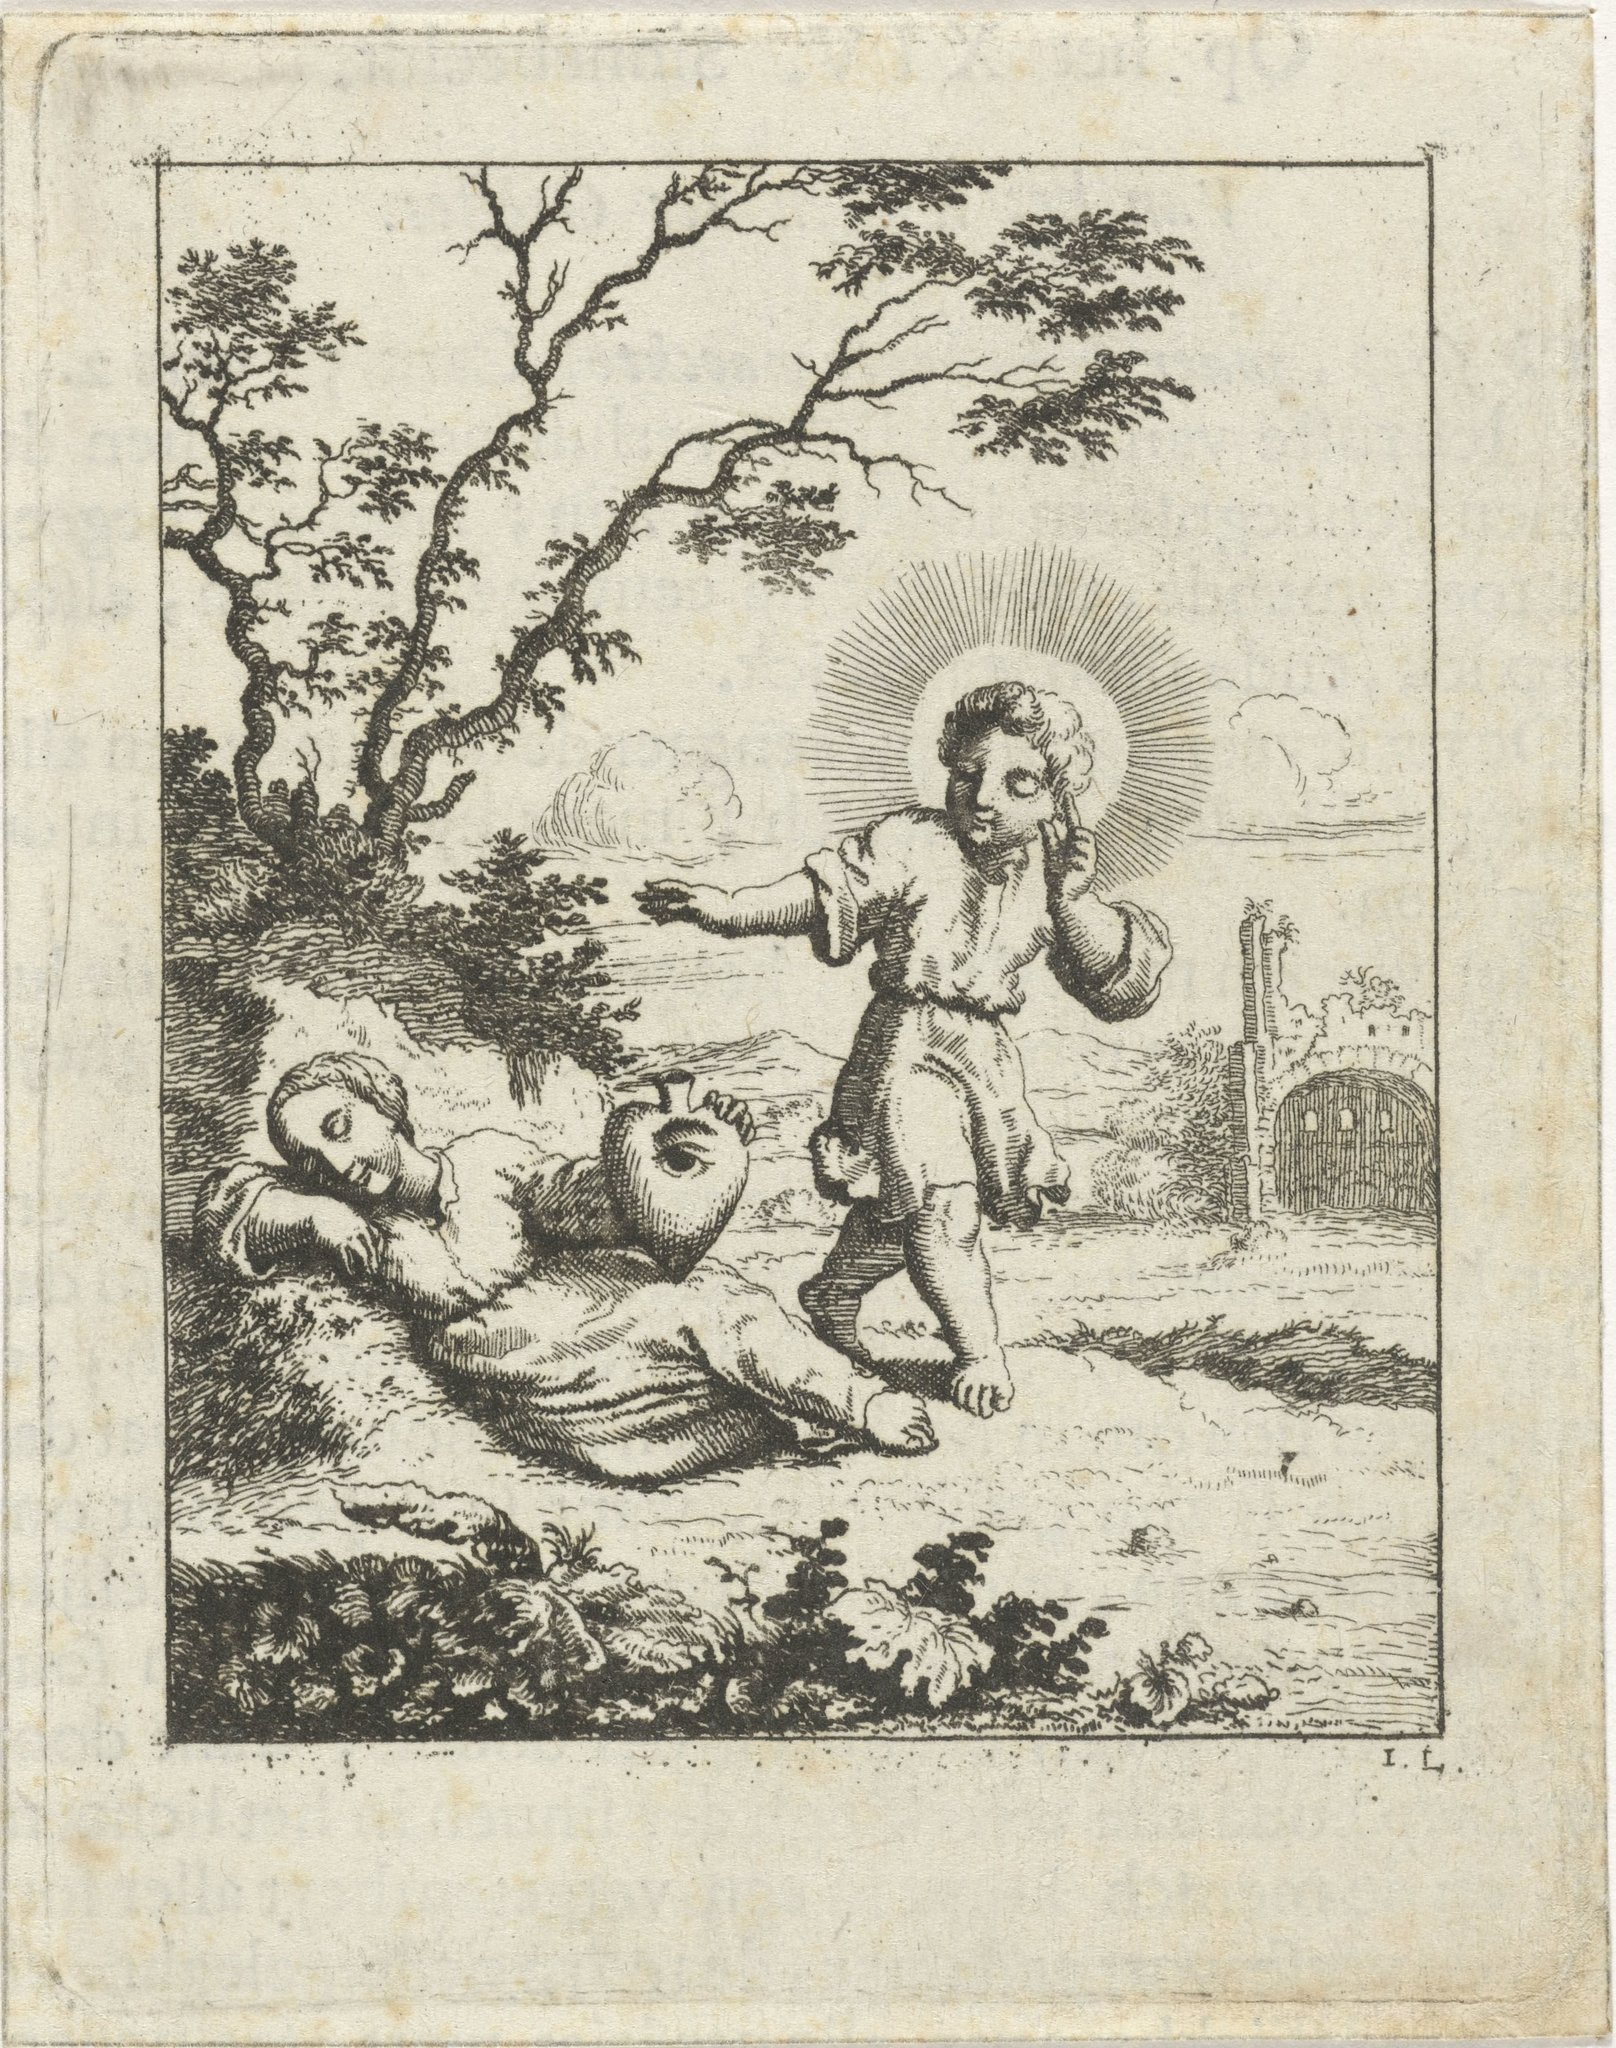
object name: print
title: Christus vindt de gepersonifieerde ziel slapend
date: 1678-1687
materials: paper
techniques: etching, letterpress printing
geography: amsterdam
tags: sleeping; unconsciousness, christ and the soul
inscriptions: collector's mark: Lugt 2228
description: Illustratie uit: Luyken, Jan. Jezus en de Ziel, 3 delen. Amsterdam: Pieter Arentsz II, 1678-1687. Tussen 1678-1744 verschenen van dit emblemataboek 10 edities.